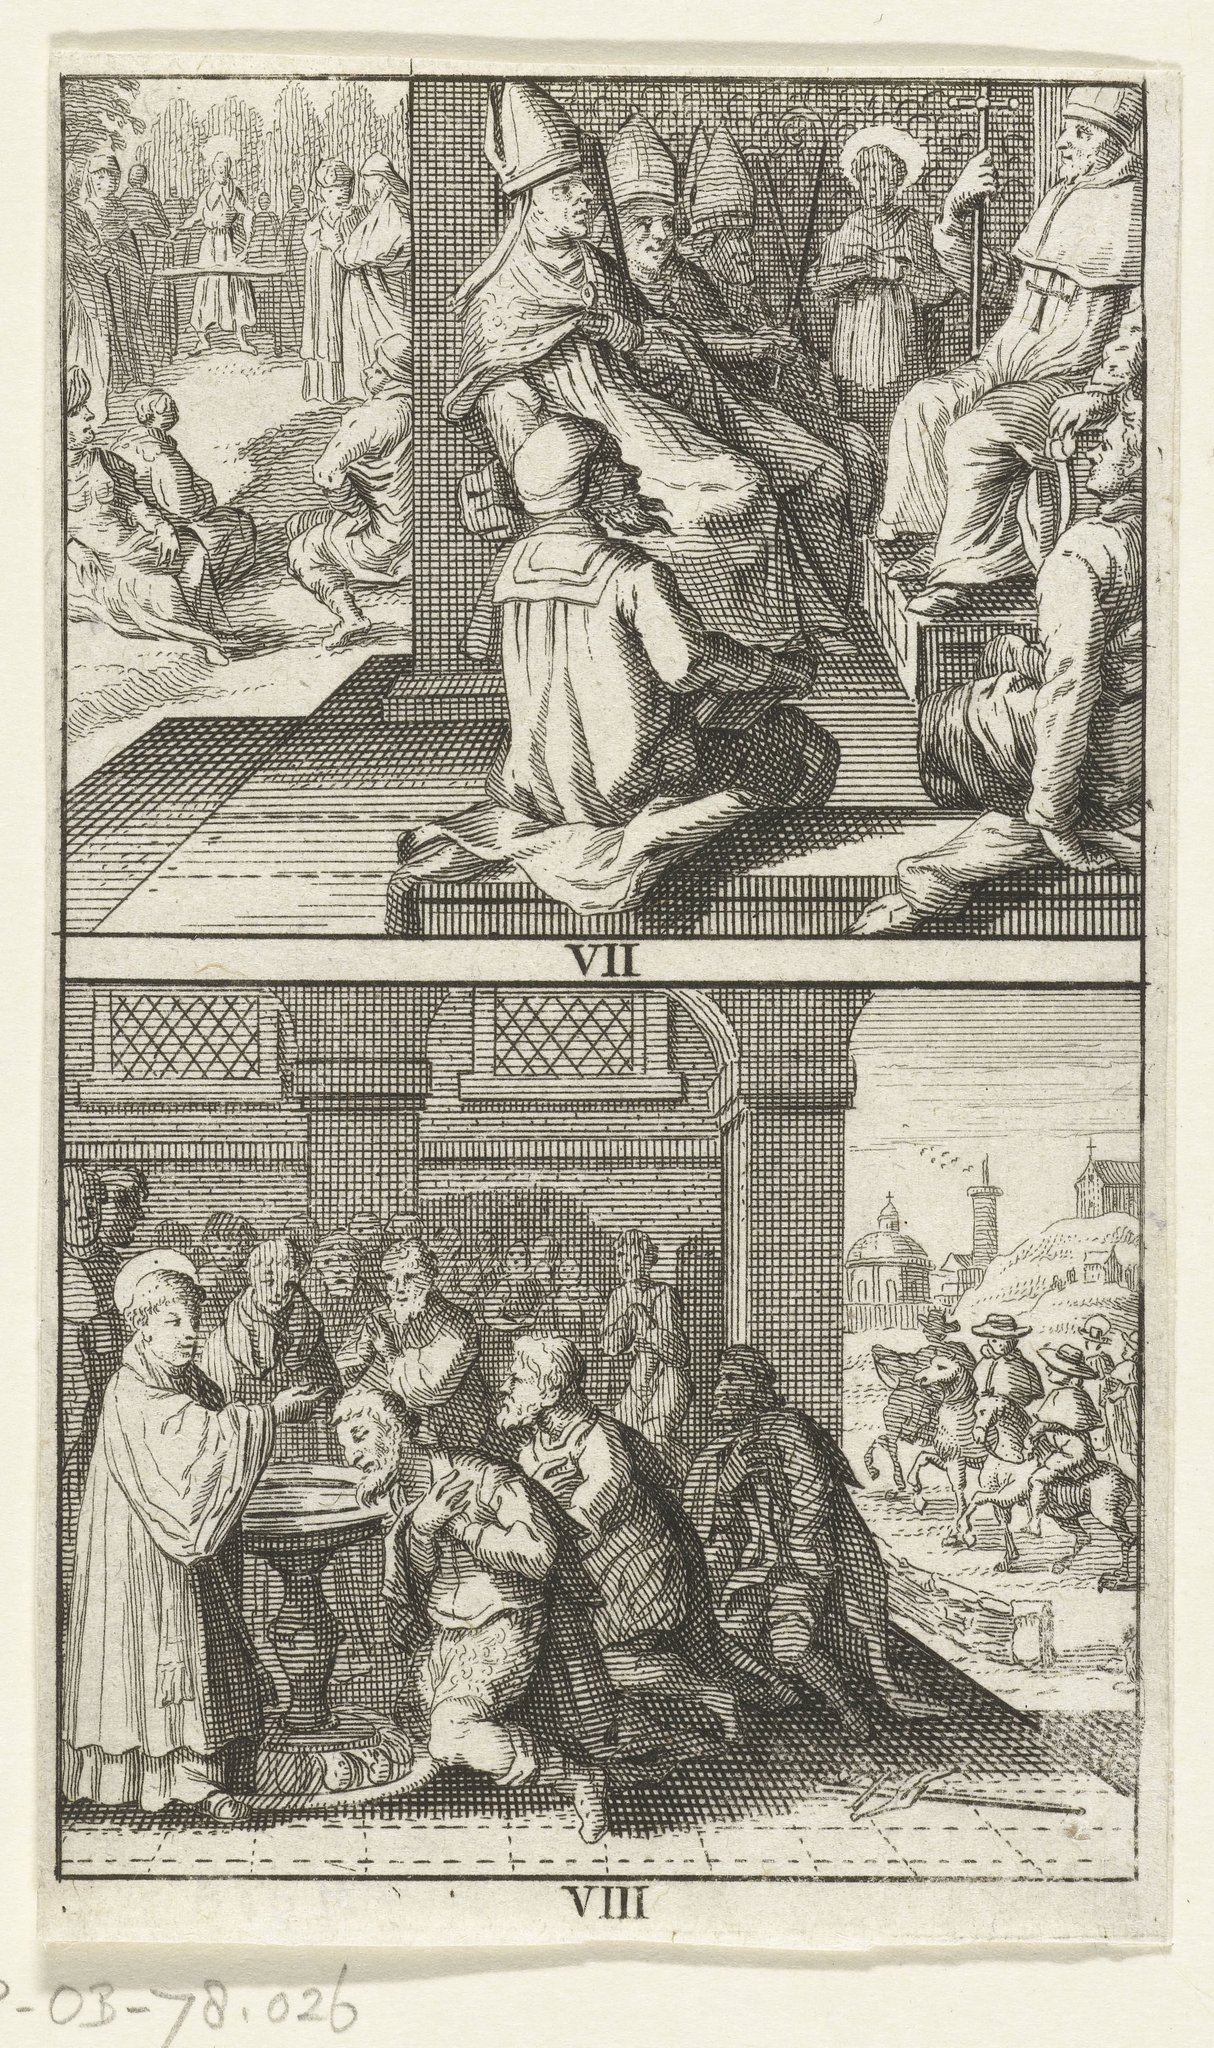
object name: print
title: Scènes uit het leven van de heilige Bonifatius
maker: Anonymous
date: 1640-1659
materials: paper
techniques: etching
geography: low countries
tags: the martyr boniface, 'apostle of germany', and archbishop of mainz; possible attributes: axe in root of tree, book pierced by a sword, fountain (springing up from under his staff), whip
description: Scènes uit het leven van de heilige Bonifatius, platen VII en VIII. De heilige tussen bisschoppen en dopend. Vijfde prent in een serie prenten over het leven van de heilige Bonifatius, bestaande uit een grote afbeelding van de heilige gevolgd door 8 platen met telkens twee kleinere genummerde voorstellingen onder elkaar.